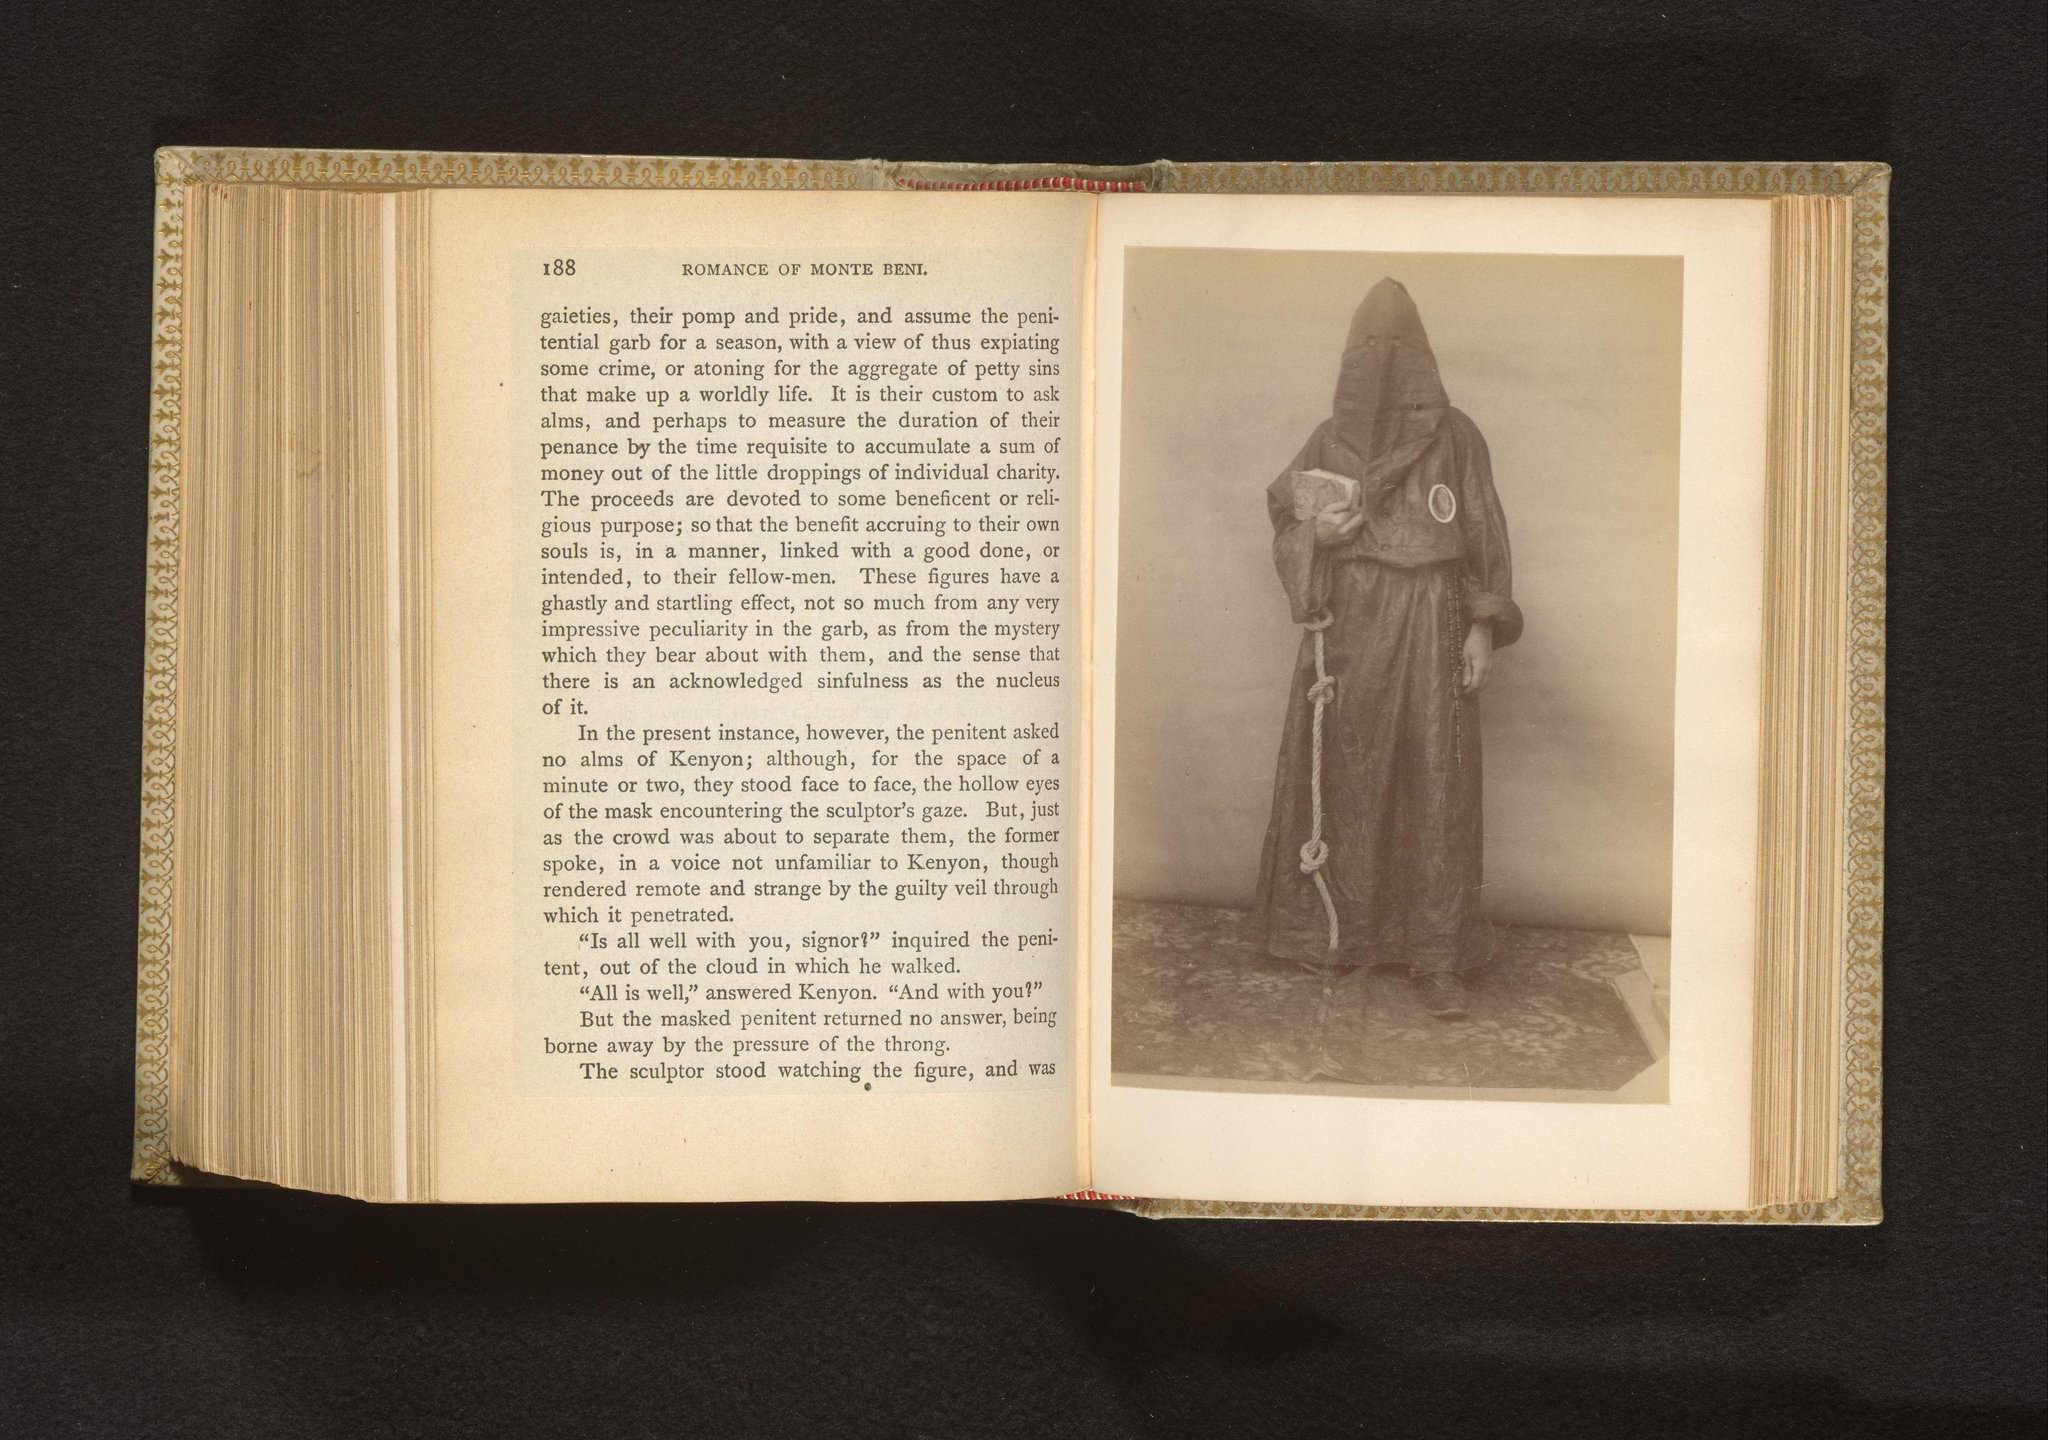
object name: photograph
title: Portret van iemand in een monnikspij en met een kap over het hoofd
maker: Anonymous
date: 1850-1860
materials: photographic support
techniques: albumen print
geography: italy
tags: monks and nuns